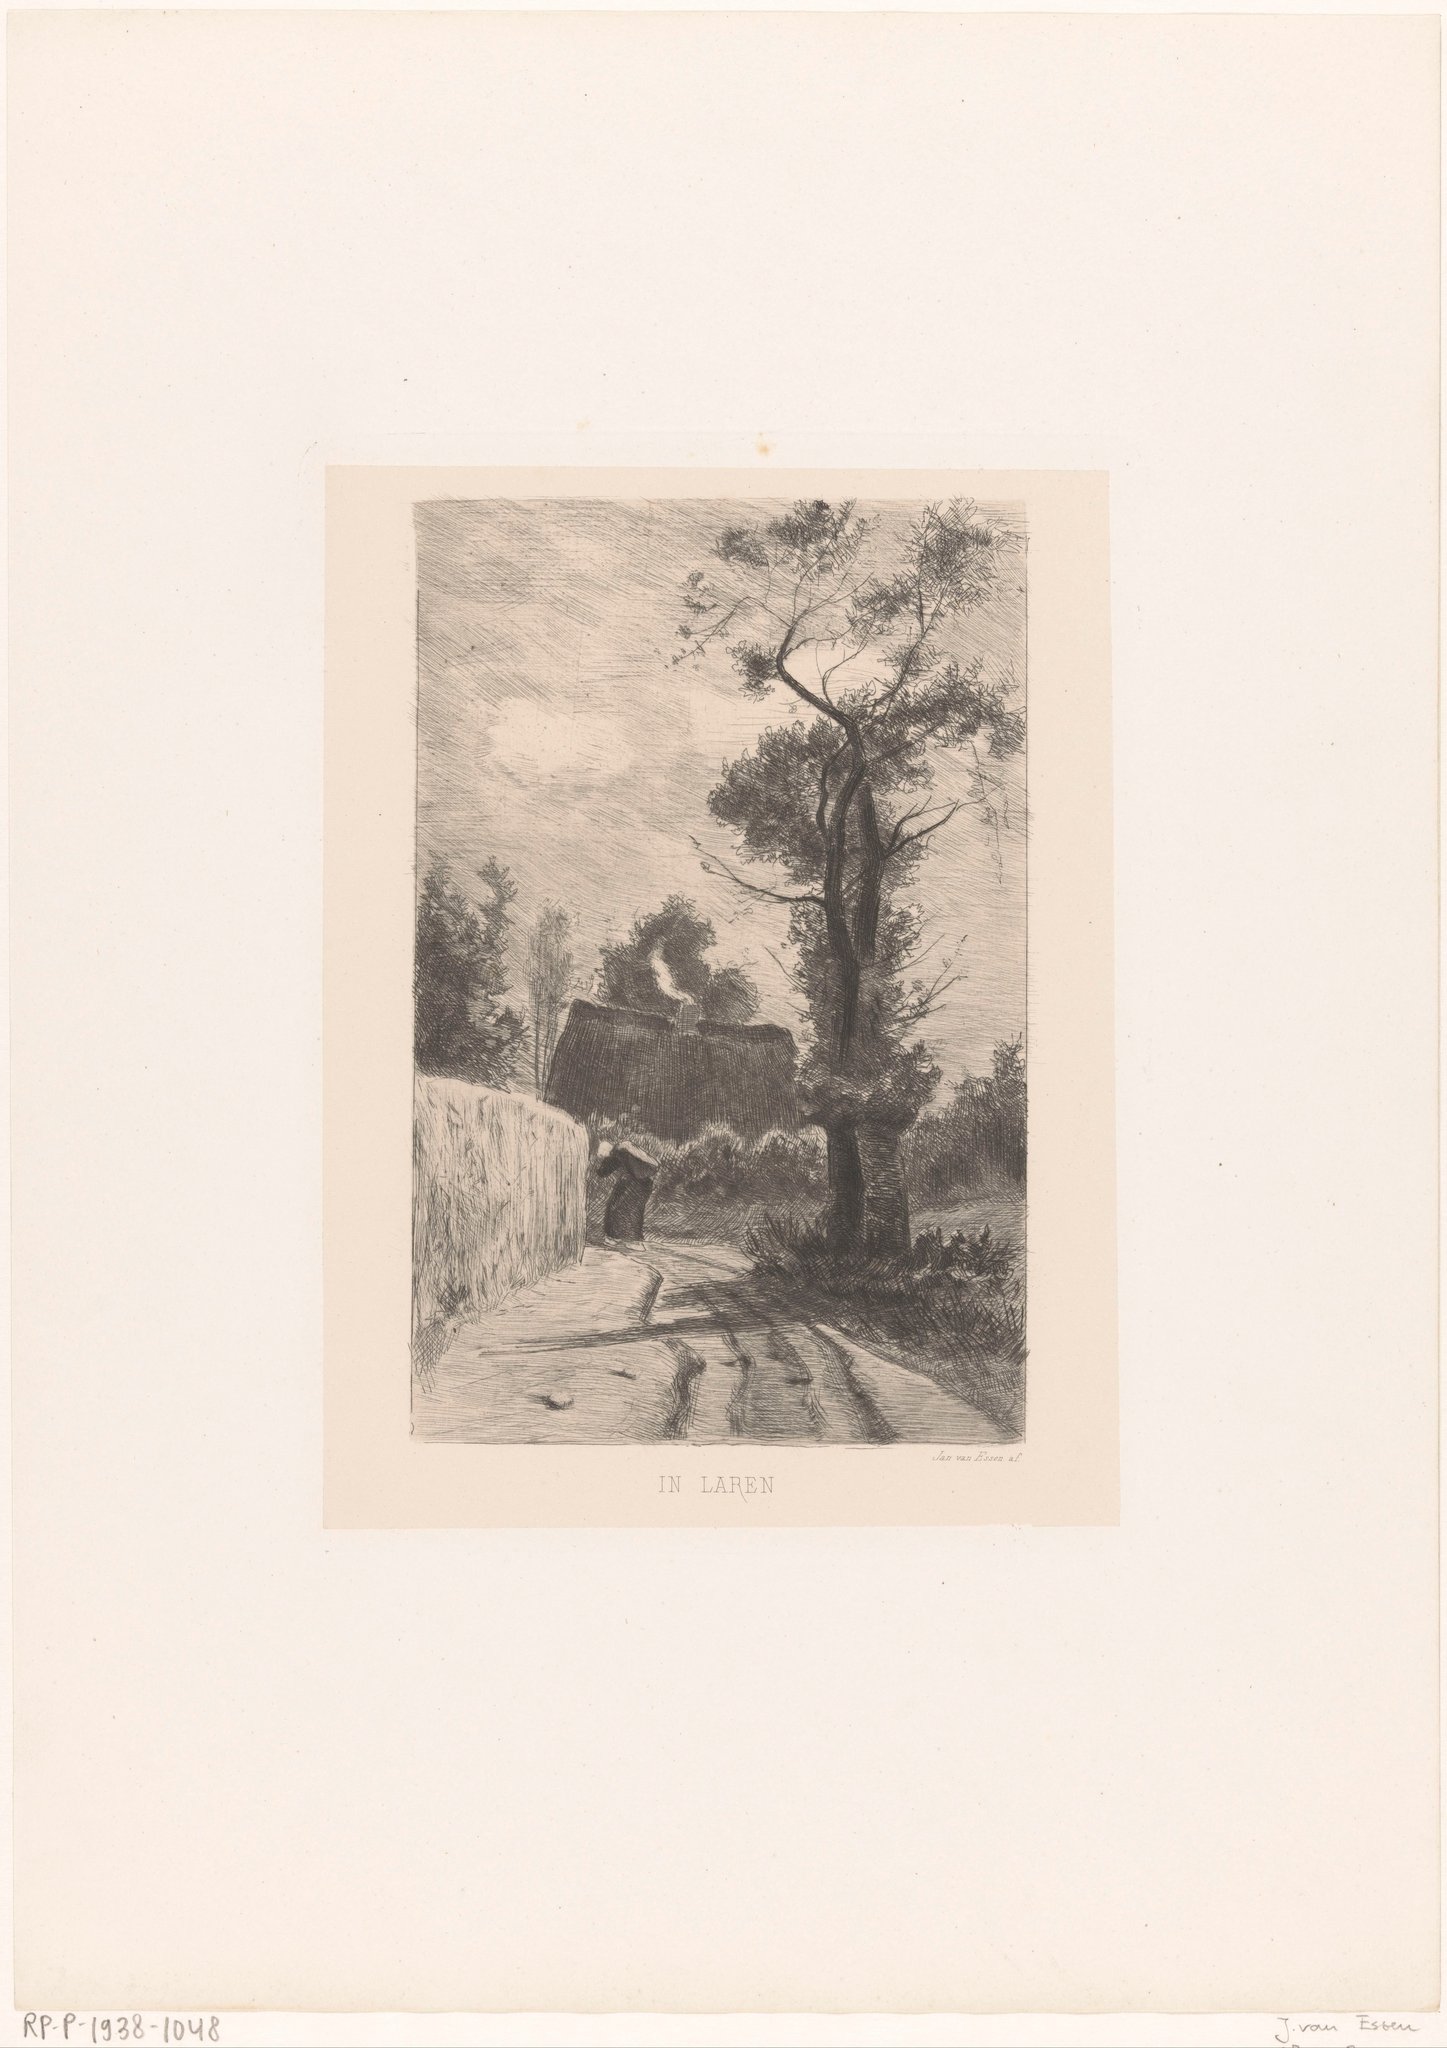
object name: print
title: In Laren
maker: jan van essen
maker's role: draughtsman, print maker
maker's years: 1854-1936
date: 1864-1936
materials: paper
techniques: etching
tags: road, path, carrying something on the head or on the shoulders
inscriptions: collector's mark: Lugt 2228, collector's mark: Lugt 2760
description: Een vrouw draagt een zak op haar rug op een pad. Links van het pas een haag, rechts twee bomen. Op de achtergrond een huis met rokende schoorsteen.